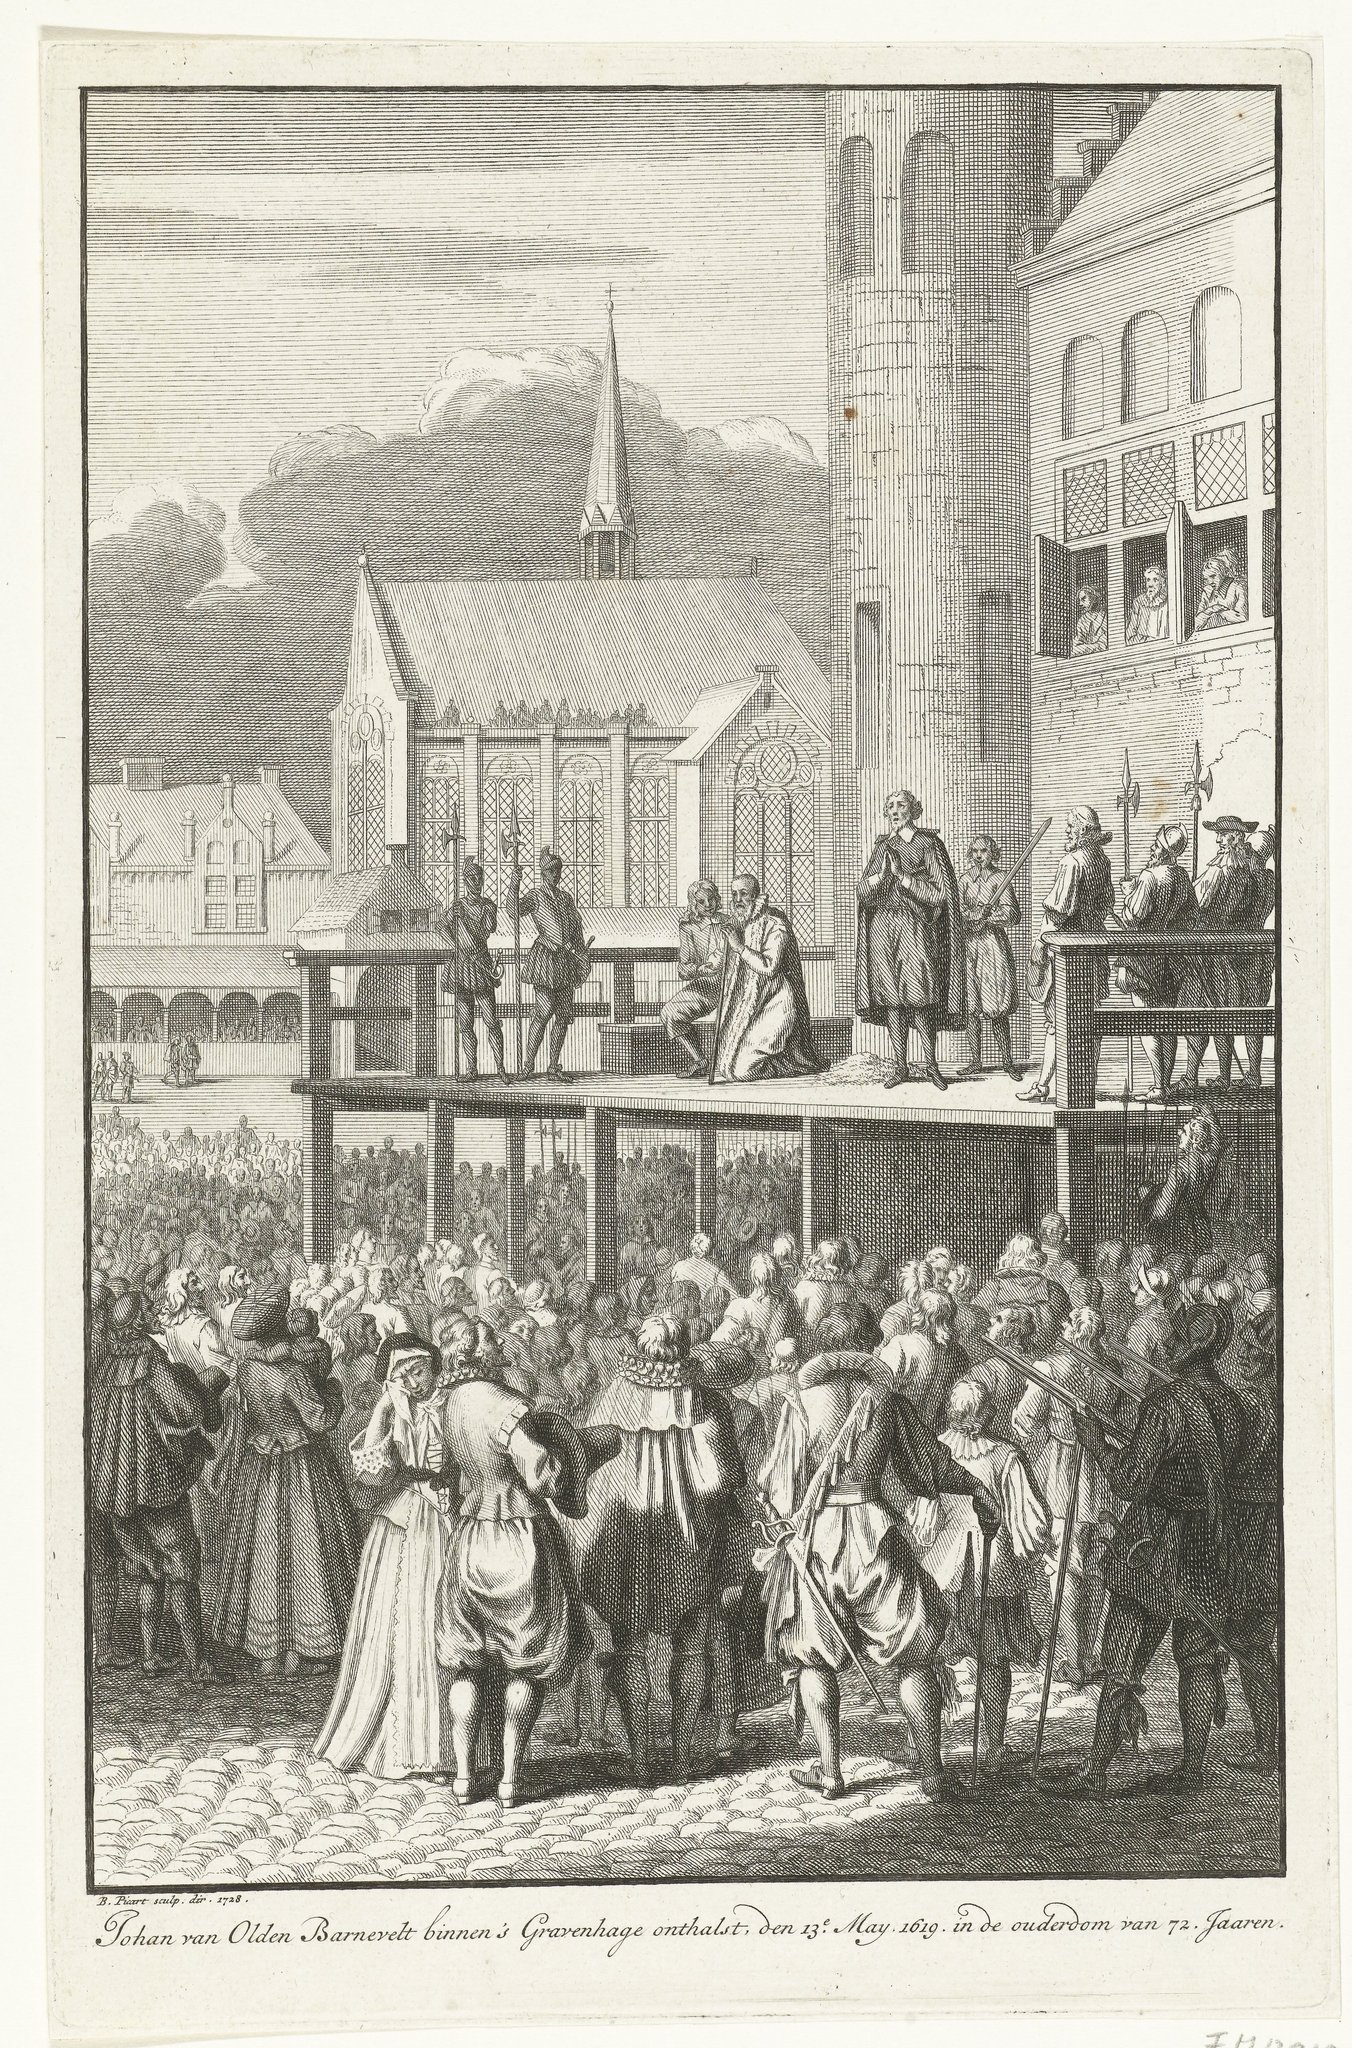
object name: print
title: Johan van Olden Barnevelt binnen 's Gravenhage onthalst, den 13e. May. 1619. in de ouderdom van 72. Jaaren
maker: bernard picart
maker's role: draughtsman, print maker, publisher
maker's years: 1673-1733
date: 1728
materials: paper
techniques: etching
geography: northern netherlands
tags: the hague, johan van oldenbarnevelt, on the scaffold or place of execution, violent death by beheading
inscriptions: date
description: Gebruikt als illustratie in: J. le Clerc, Geschiedenissen der Vereenigde Nederlanden, sedert den aanvang van die Republyk tot op den Vrede van Utrecht in 't jaar 1713 en het Tractaat van Barriere in 't jaar 1715 gesloten, Z. Chatelain, Amsterdam 1730, 3 delen.